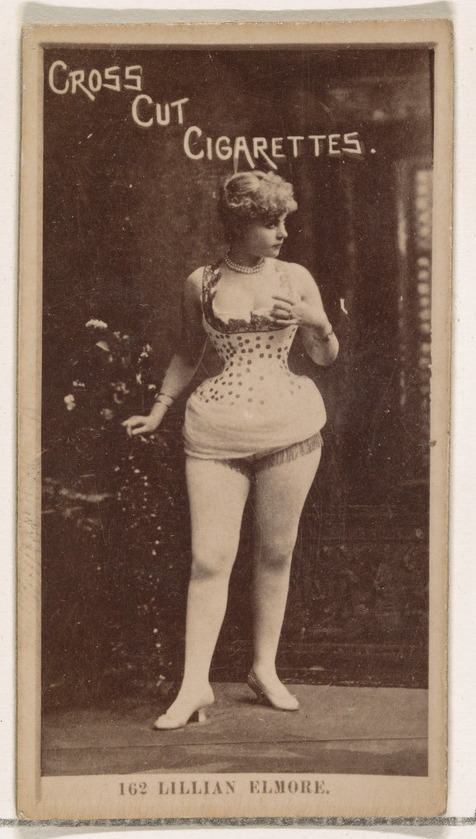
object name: print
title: Card Number 162, Lillian Elmore, from the Actors and Actresses series (N145-2) issued by Duke Sons & Co. to promote Cross Cut Cigarettes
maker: w. duke, sons & co.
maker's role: publisher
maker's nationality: american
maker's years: 1870-1920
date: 1880-1889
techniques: albumen silver print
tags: portraits,women,actresses